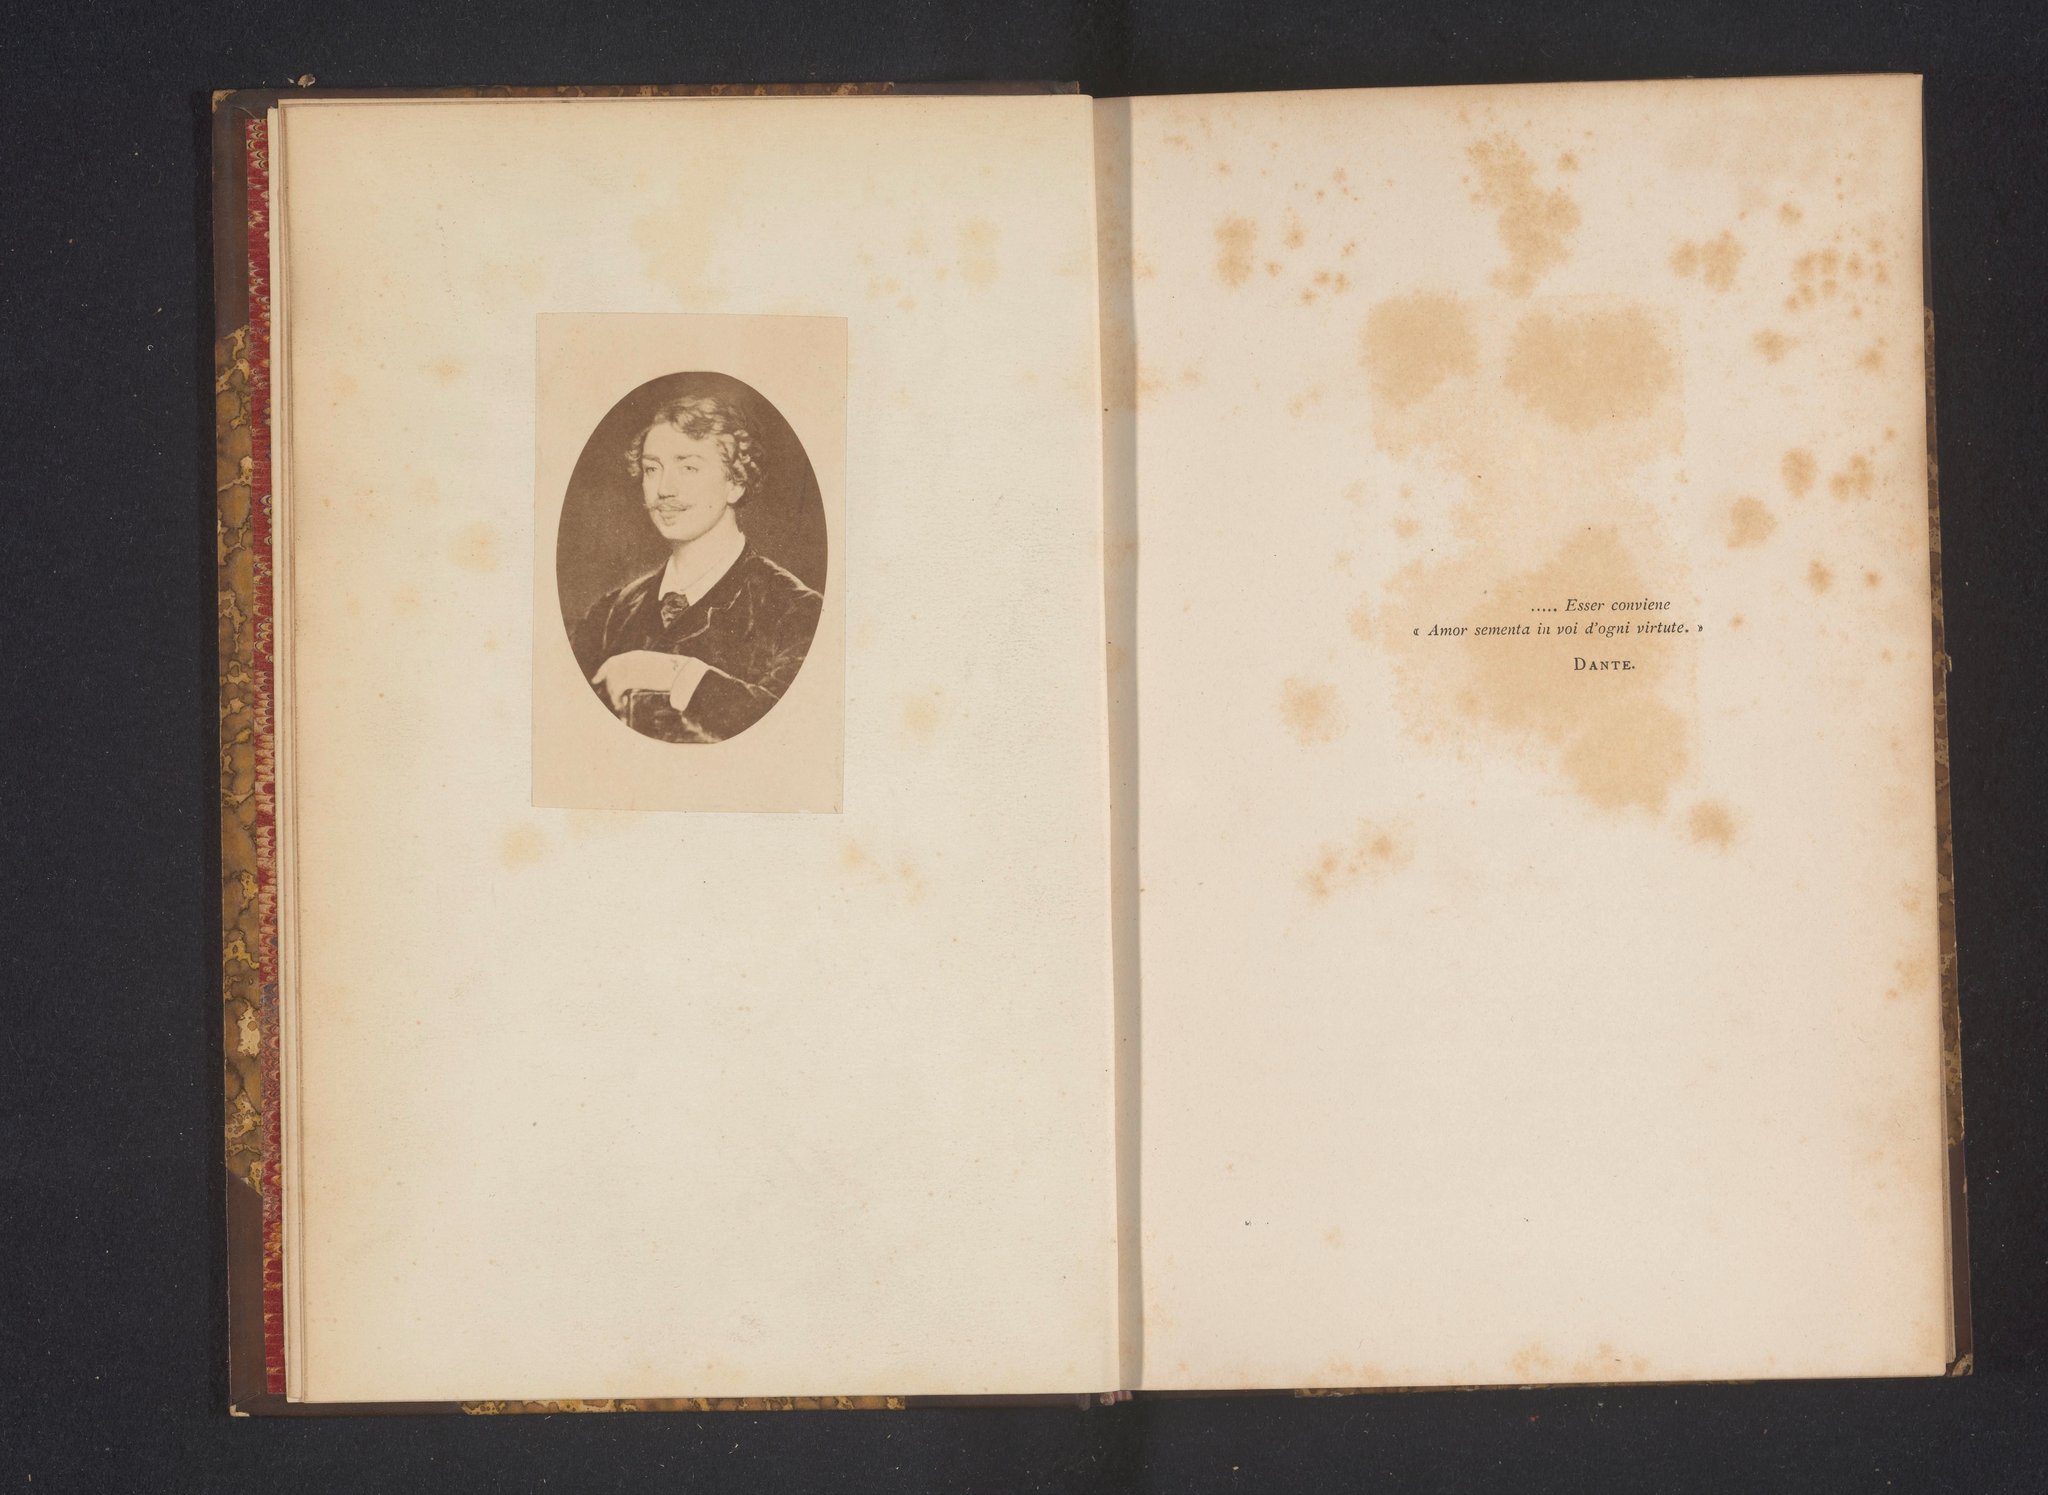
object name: photograph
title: Portret van een onbekende man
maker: Anonymous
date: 1872-1877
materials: photographic support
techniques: albumen print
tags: adult man, historical persons